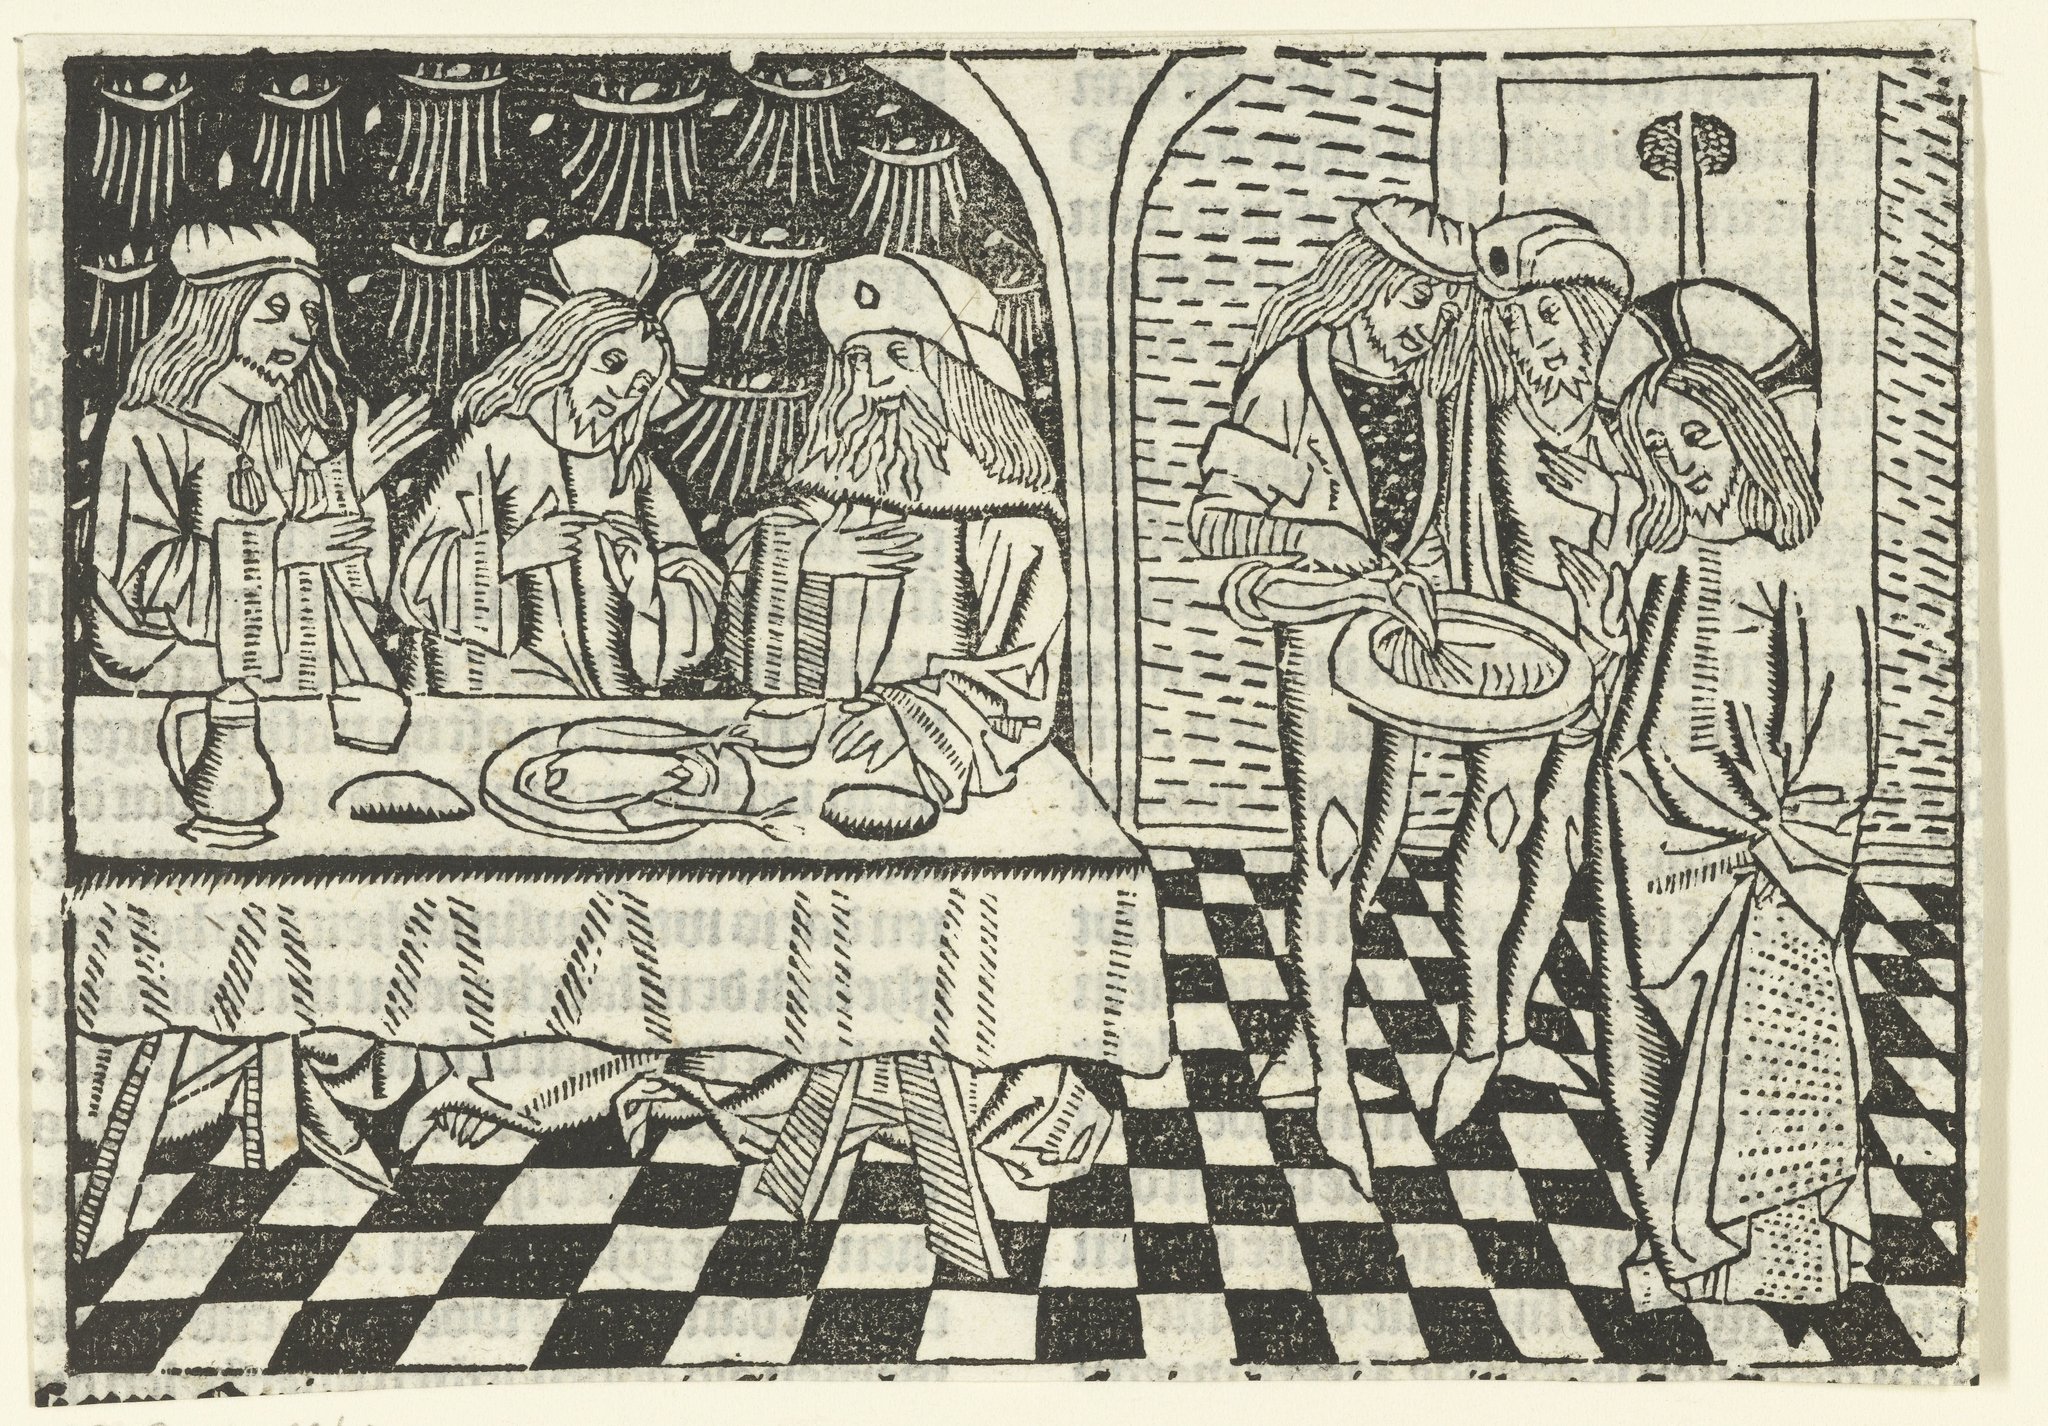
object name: print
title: Maaltijd bij de Farizeeërs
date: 1480-1500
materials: paper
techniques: woodcut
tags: meal at the house of a pharisee; christ and his disciples do not submit to the ritual washing (luke 11:37-41)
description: Eén blad van 113 uit Ludolphus de Saxonia, "Dit es dleué ons liefs heeren ihesu christi". Anonieme Nederlandse vertaling. Uitgegeven door Henrick Eckert van Homberch te Antwerpen in 1503. Botke, K. Deze 113 houtsneden, die meestal reeds in vroege Nederlandse boeken gebruikt zijn, worden toegeschreven aan de tweede Meester van Delft, de Meester van de Delbecq-Schreiber-passie en de Meester van de Virgo inter Virgines. In Conway (1884) en in "De gulden passer"(1951) zijn ook eerdere versies opgenomen. Botke, K.